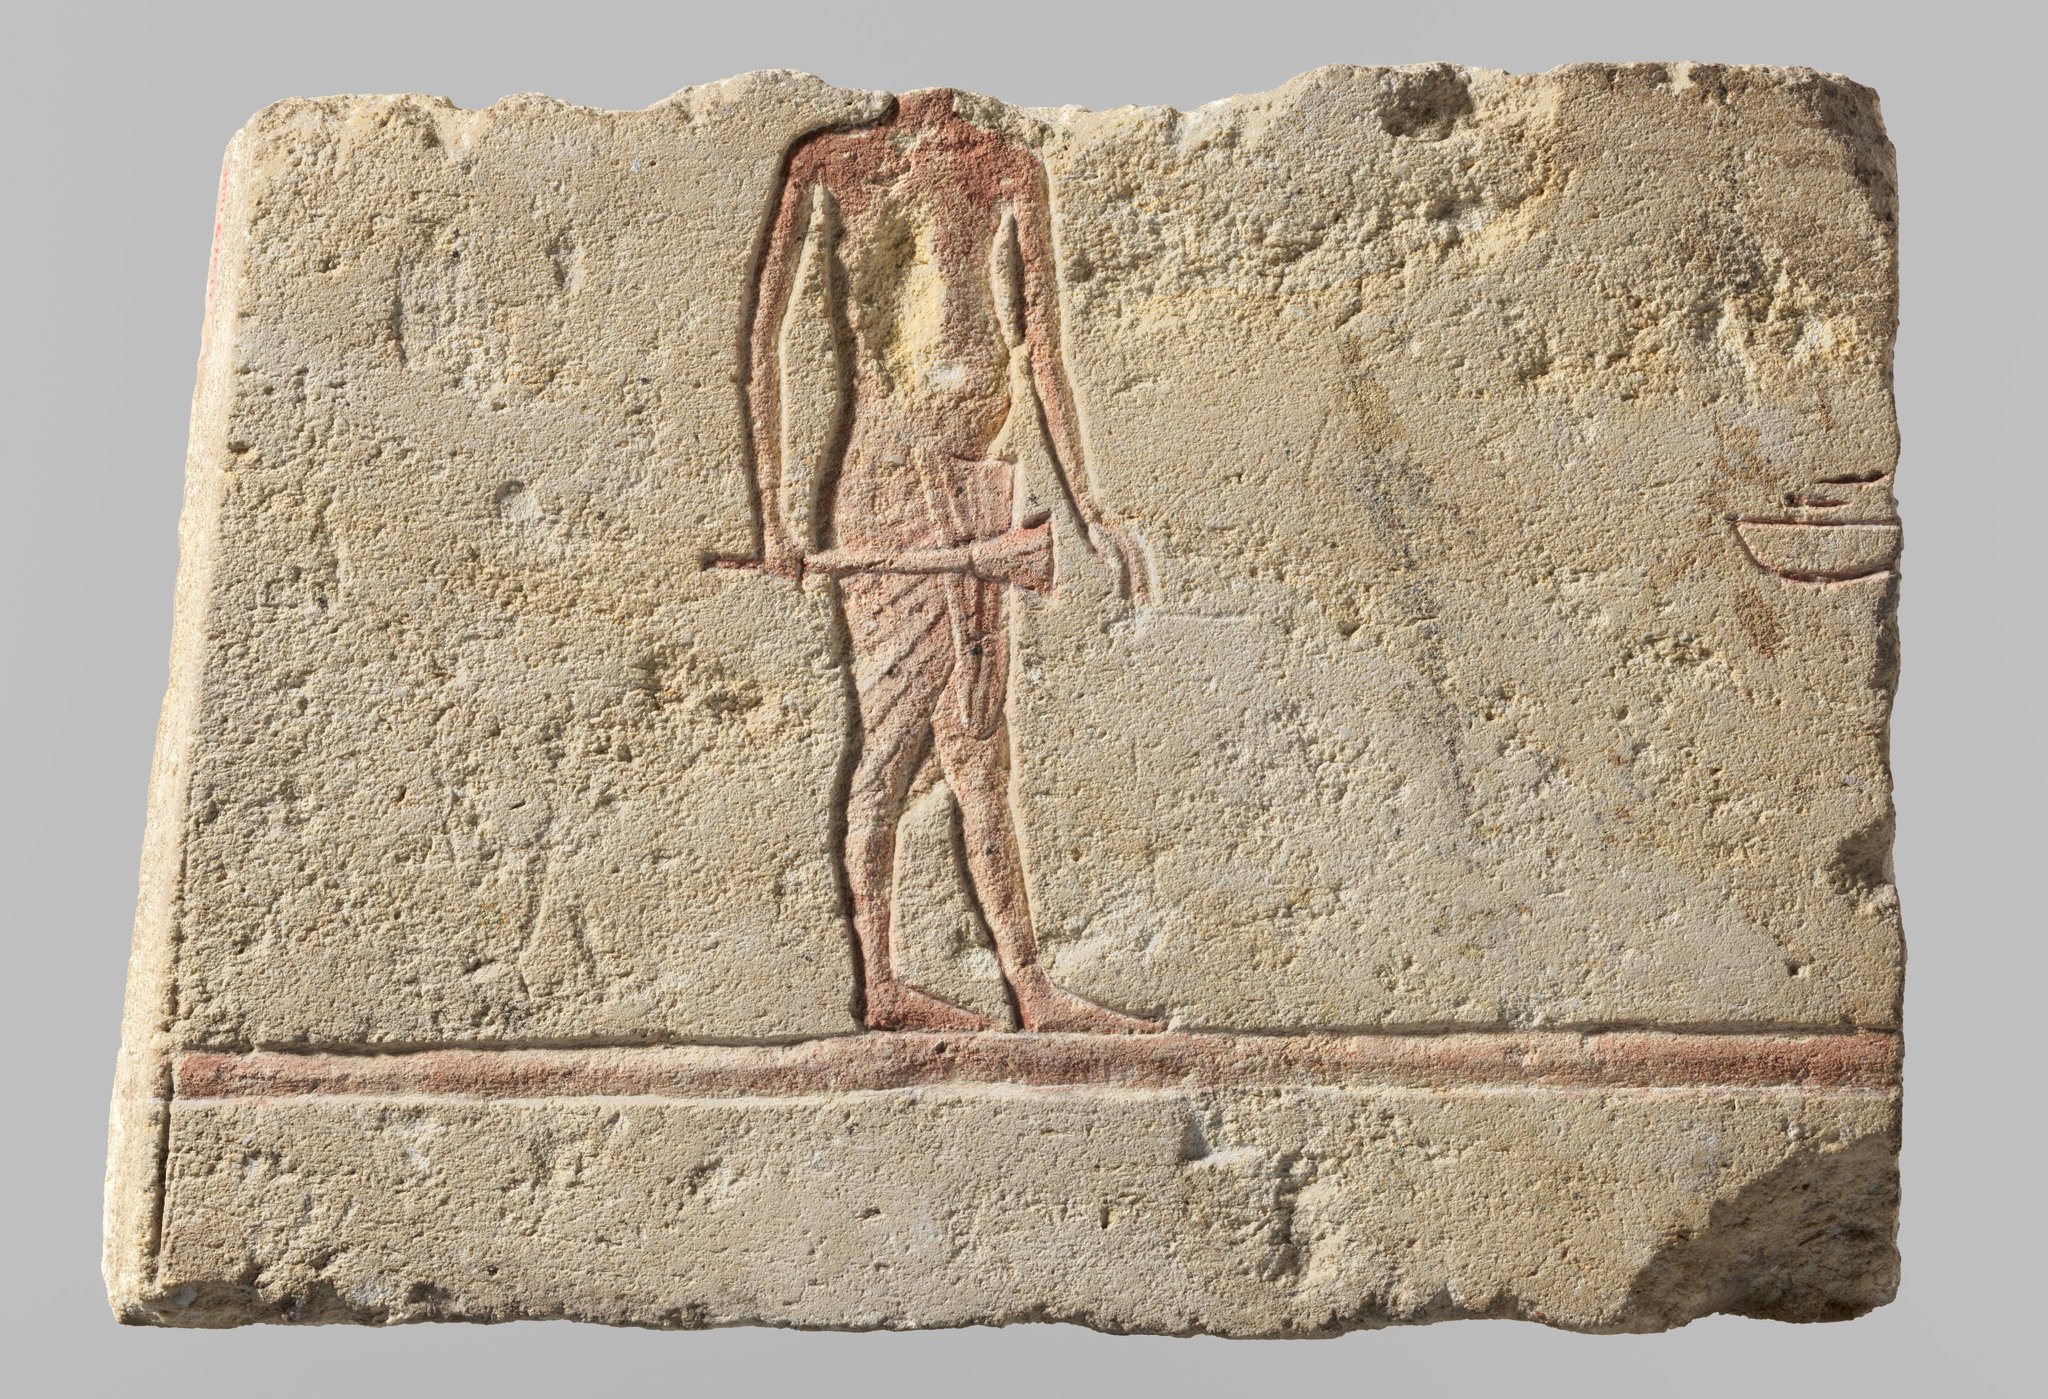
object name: talatat, trumpeter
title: Relief with trumpeter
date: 1353-1336 BCE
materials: limestone, paint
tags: men